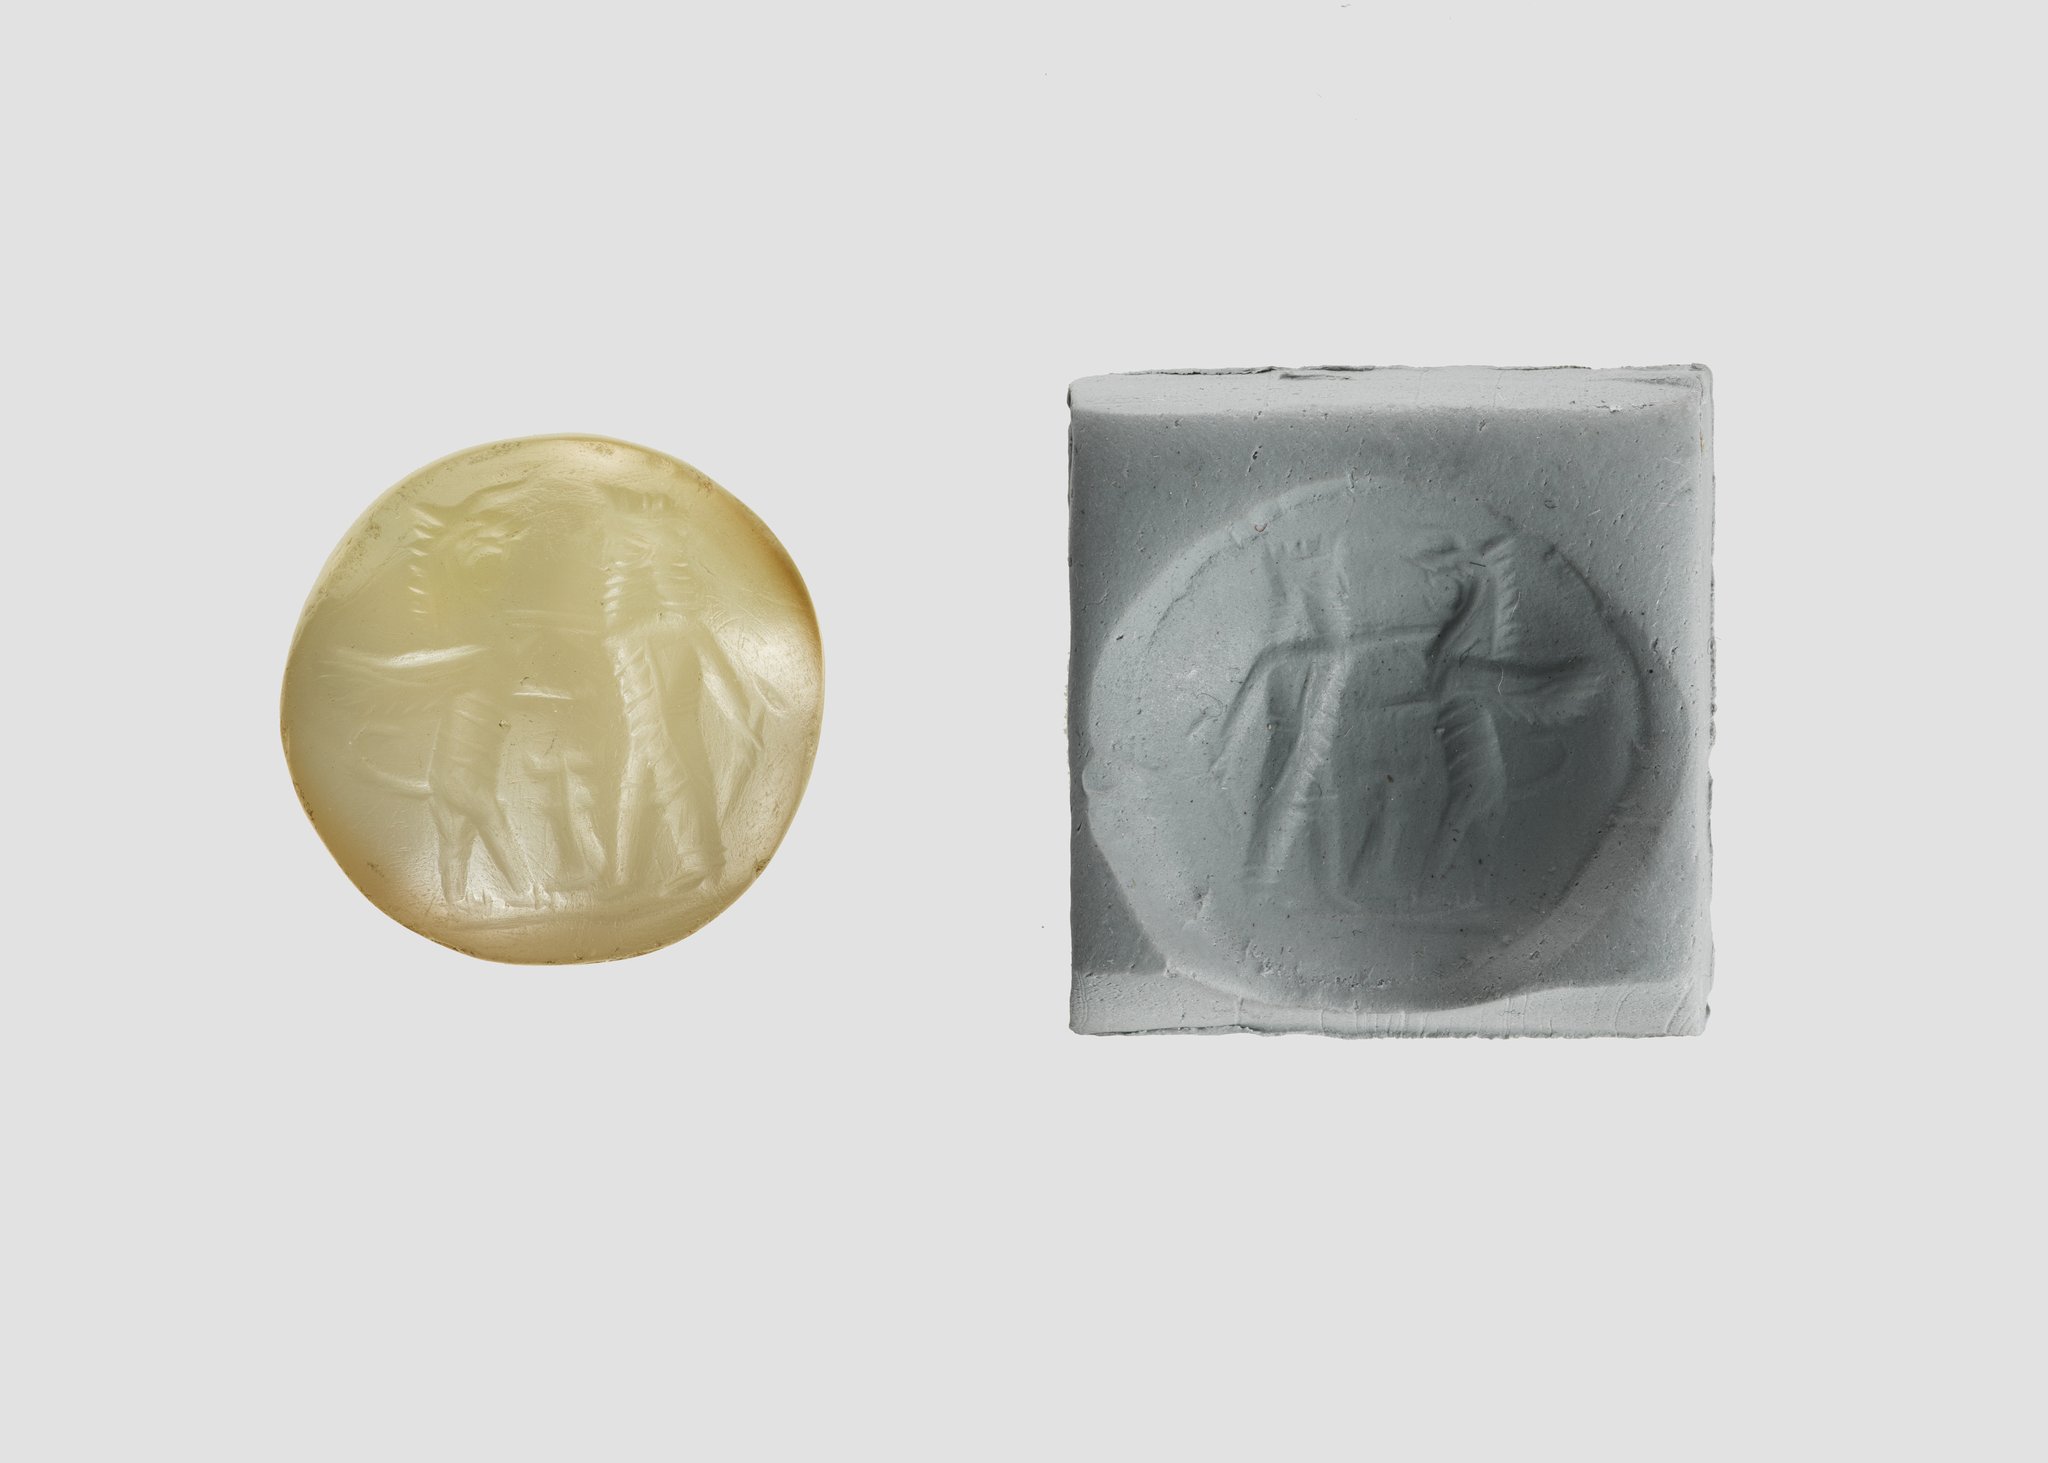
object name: stamp seal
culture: achaemenid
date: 600-301 BCE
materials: stone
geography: iran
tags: men,griffins